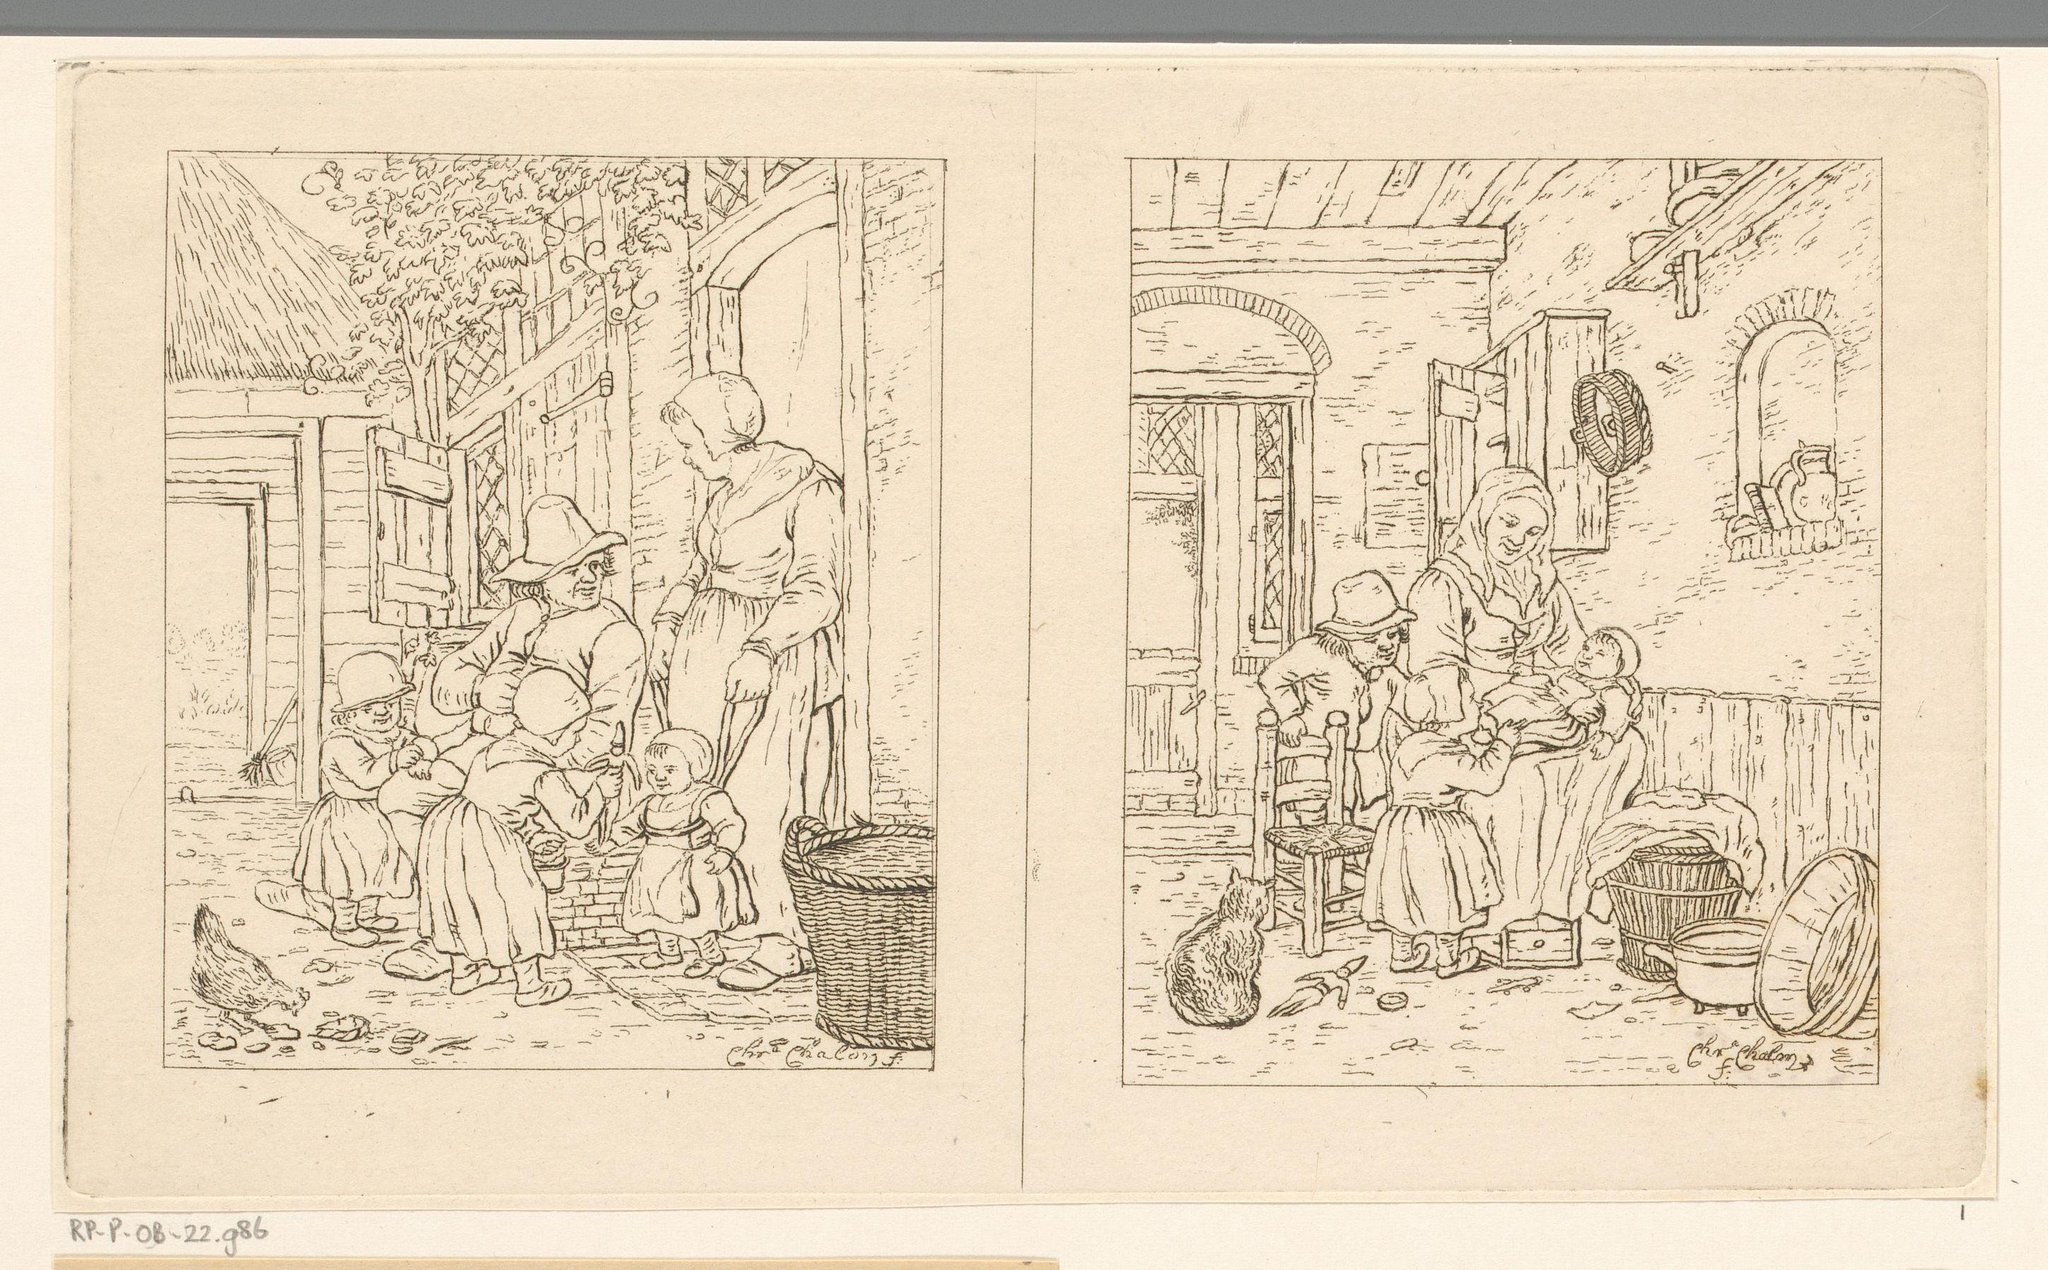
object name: print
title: Gezin voor een huis en een vrouw met kinderen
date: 1779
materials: paper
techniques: etching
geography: leiden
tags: parents with their children, mother and baby or young child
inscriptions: collector's mark: Lugt 240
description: Twee voorstellingen: links een gezin voor een huis en rechts een vrouw met kinderen in een interieur.